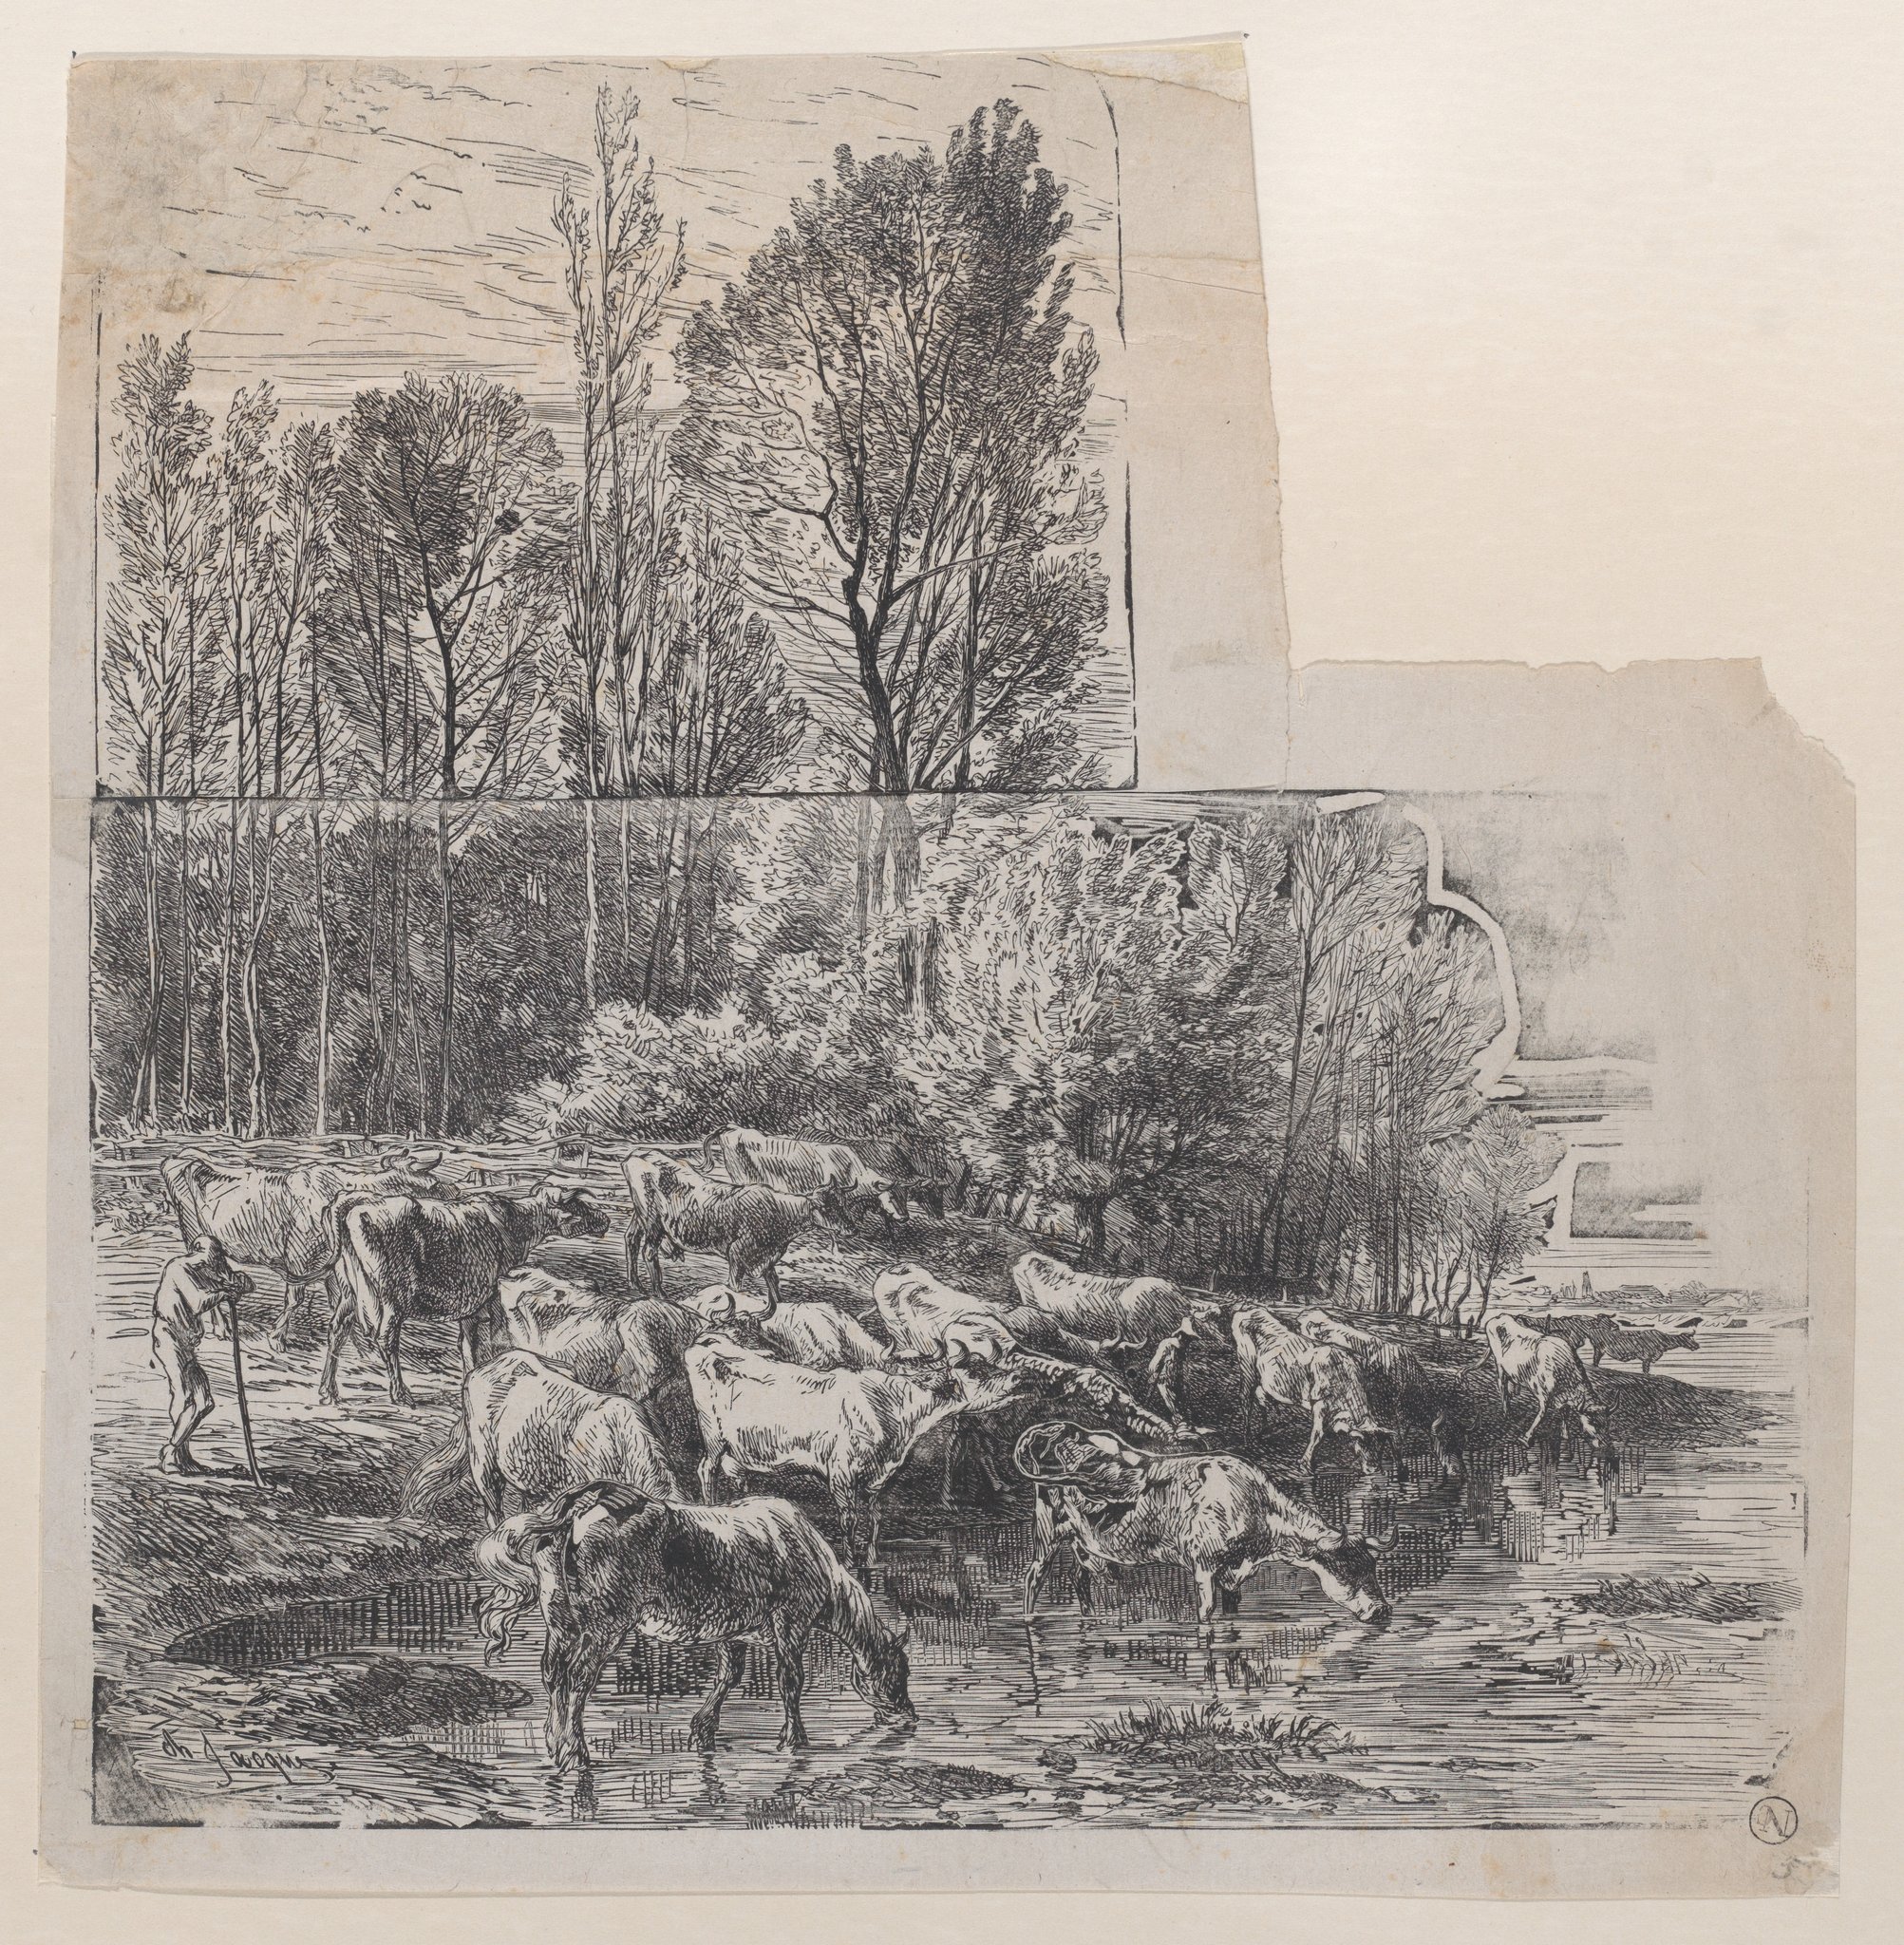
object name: print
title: Herdsman and Cattle at Ford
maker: charles émile jacque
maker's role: artist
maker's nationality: french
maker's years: 1813-1894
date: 1850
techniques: engraving